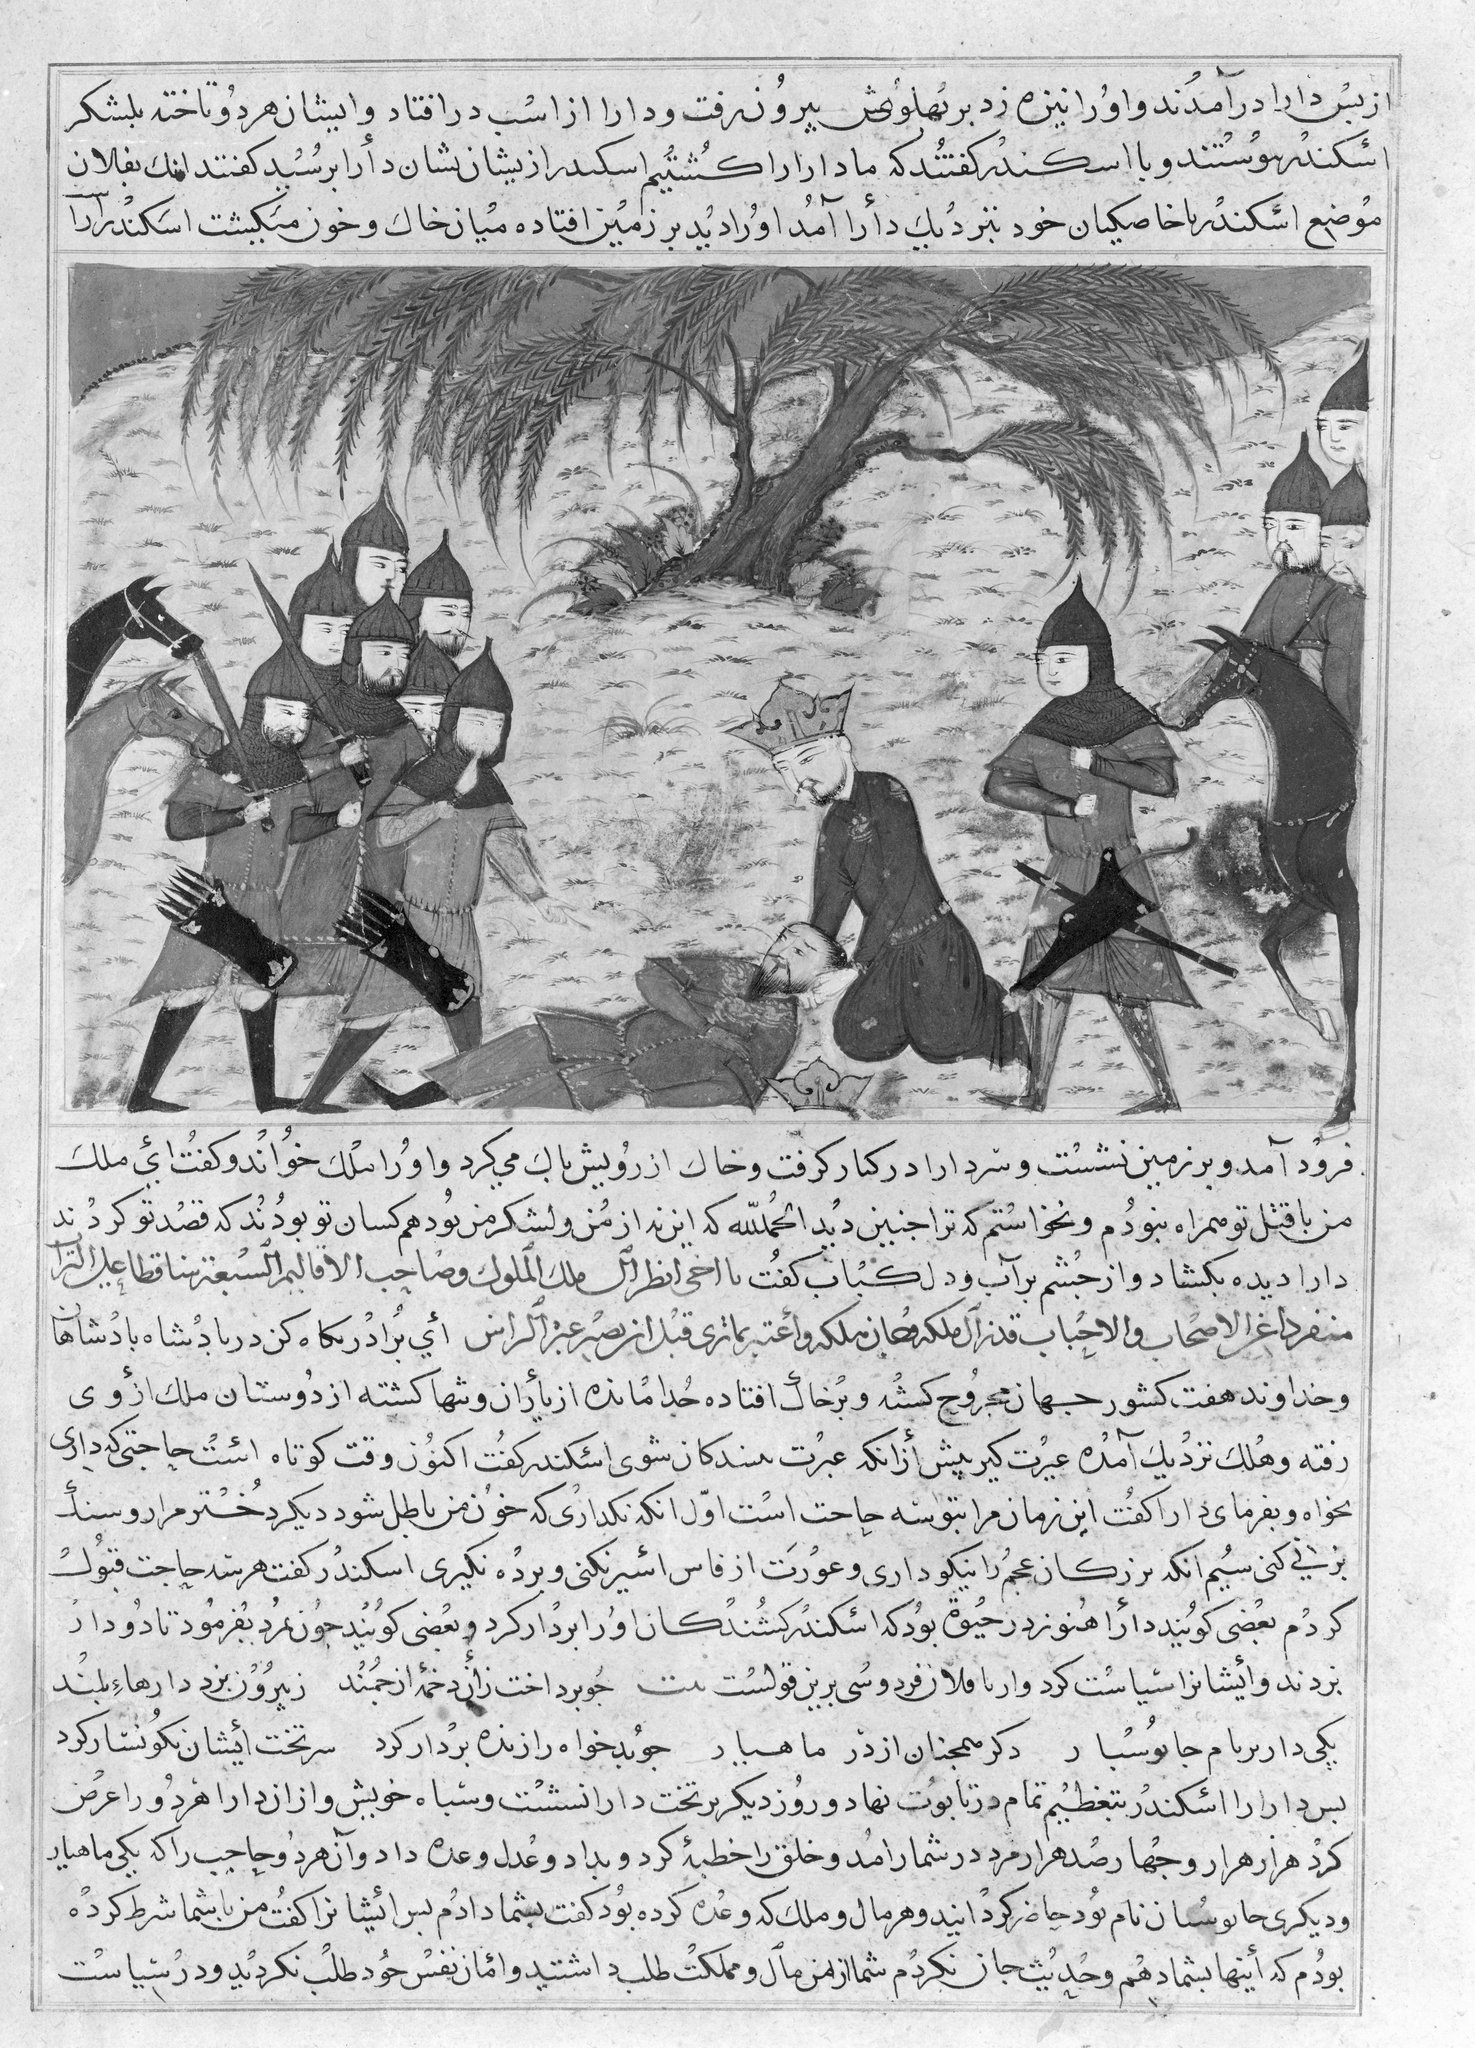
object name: folio from an illustrated manuscript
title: "Alexander the Great and Dying Darius", Folio from a Majma' al-Tavarikh (Compendium of Histories) of Hafiz-i Abru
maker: hafiz-i abru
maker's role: author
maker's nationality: iranian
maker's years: 1350-1430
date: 1425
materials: gold, paper, silver, watercolor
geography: afghanistan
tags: alexander the great,men,horses